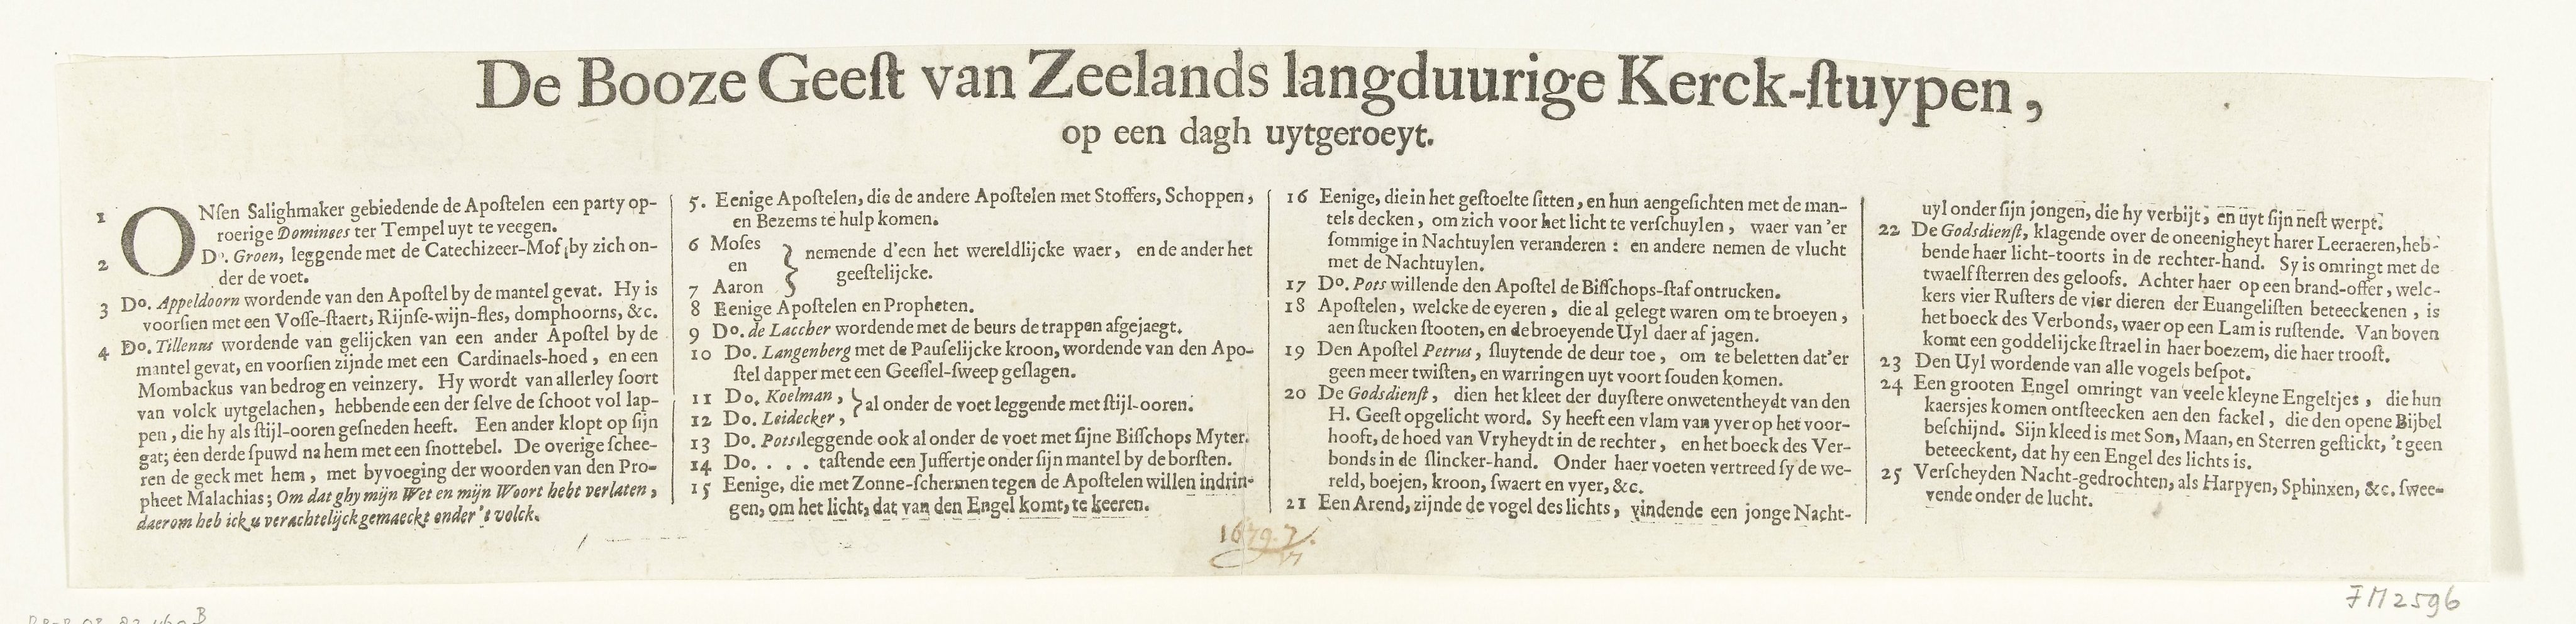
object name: print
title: Tekstblad bij de prent over de interventie van Christus in de strijd tussen de coccejanen en voetianen in Zeeland, 1676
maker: Anonymous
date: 1676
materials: paper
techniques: letterpress printing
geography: northern netherlands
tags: william iii (prince of orange and king of england, scotland, and ireland), zeeland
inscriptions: inscription: ‘1679. 7/17’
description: Tekstblad bij de prent over de interventie van Christus in de strijd tussen de coccejanen en voetianen in Zeeland in 1676. Tekst met de legenda 1-25 in 4 kolommen.